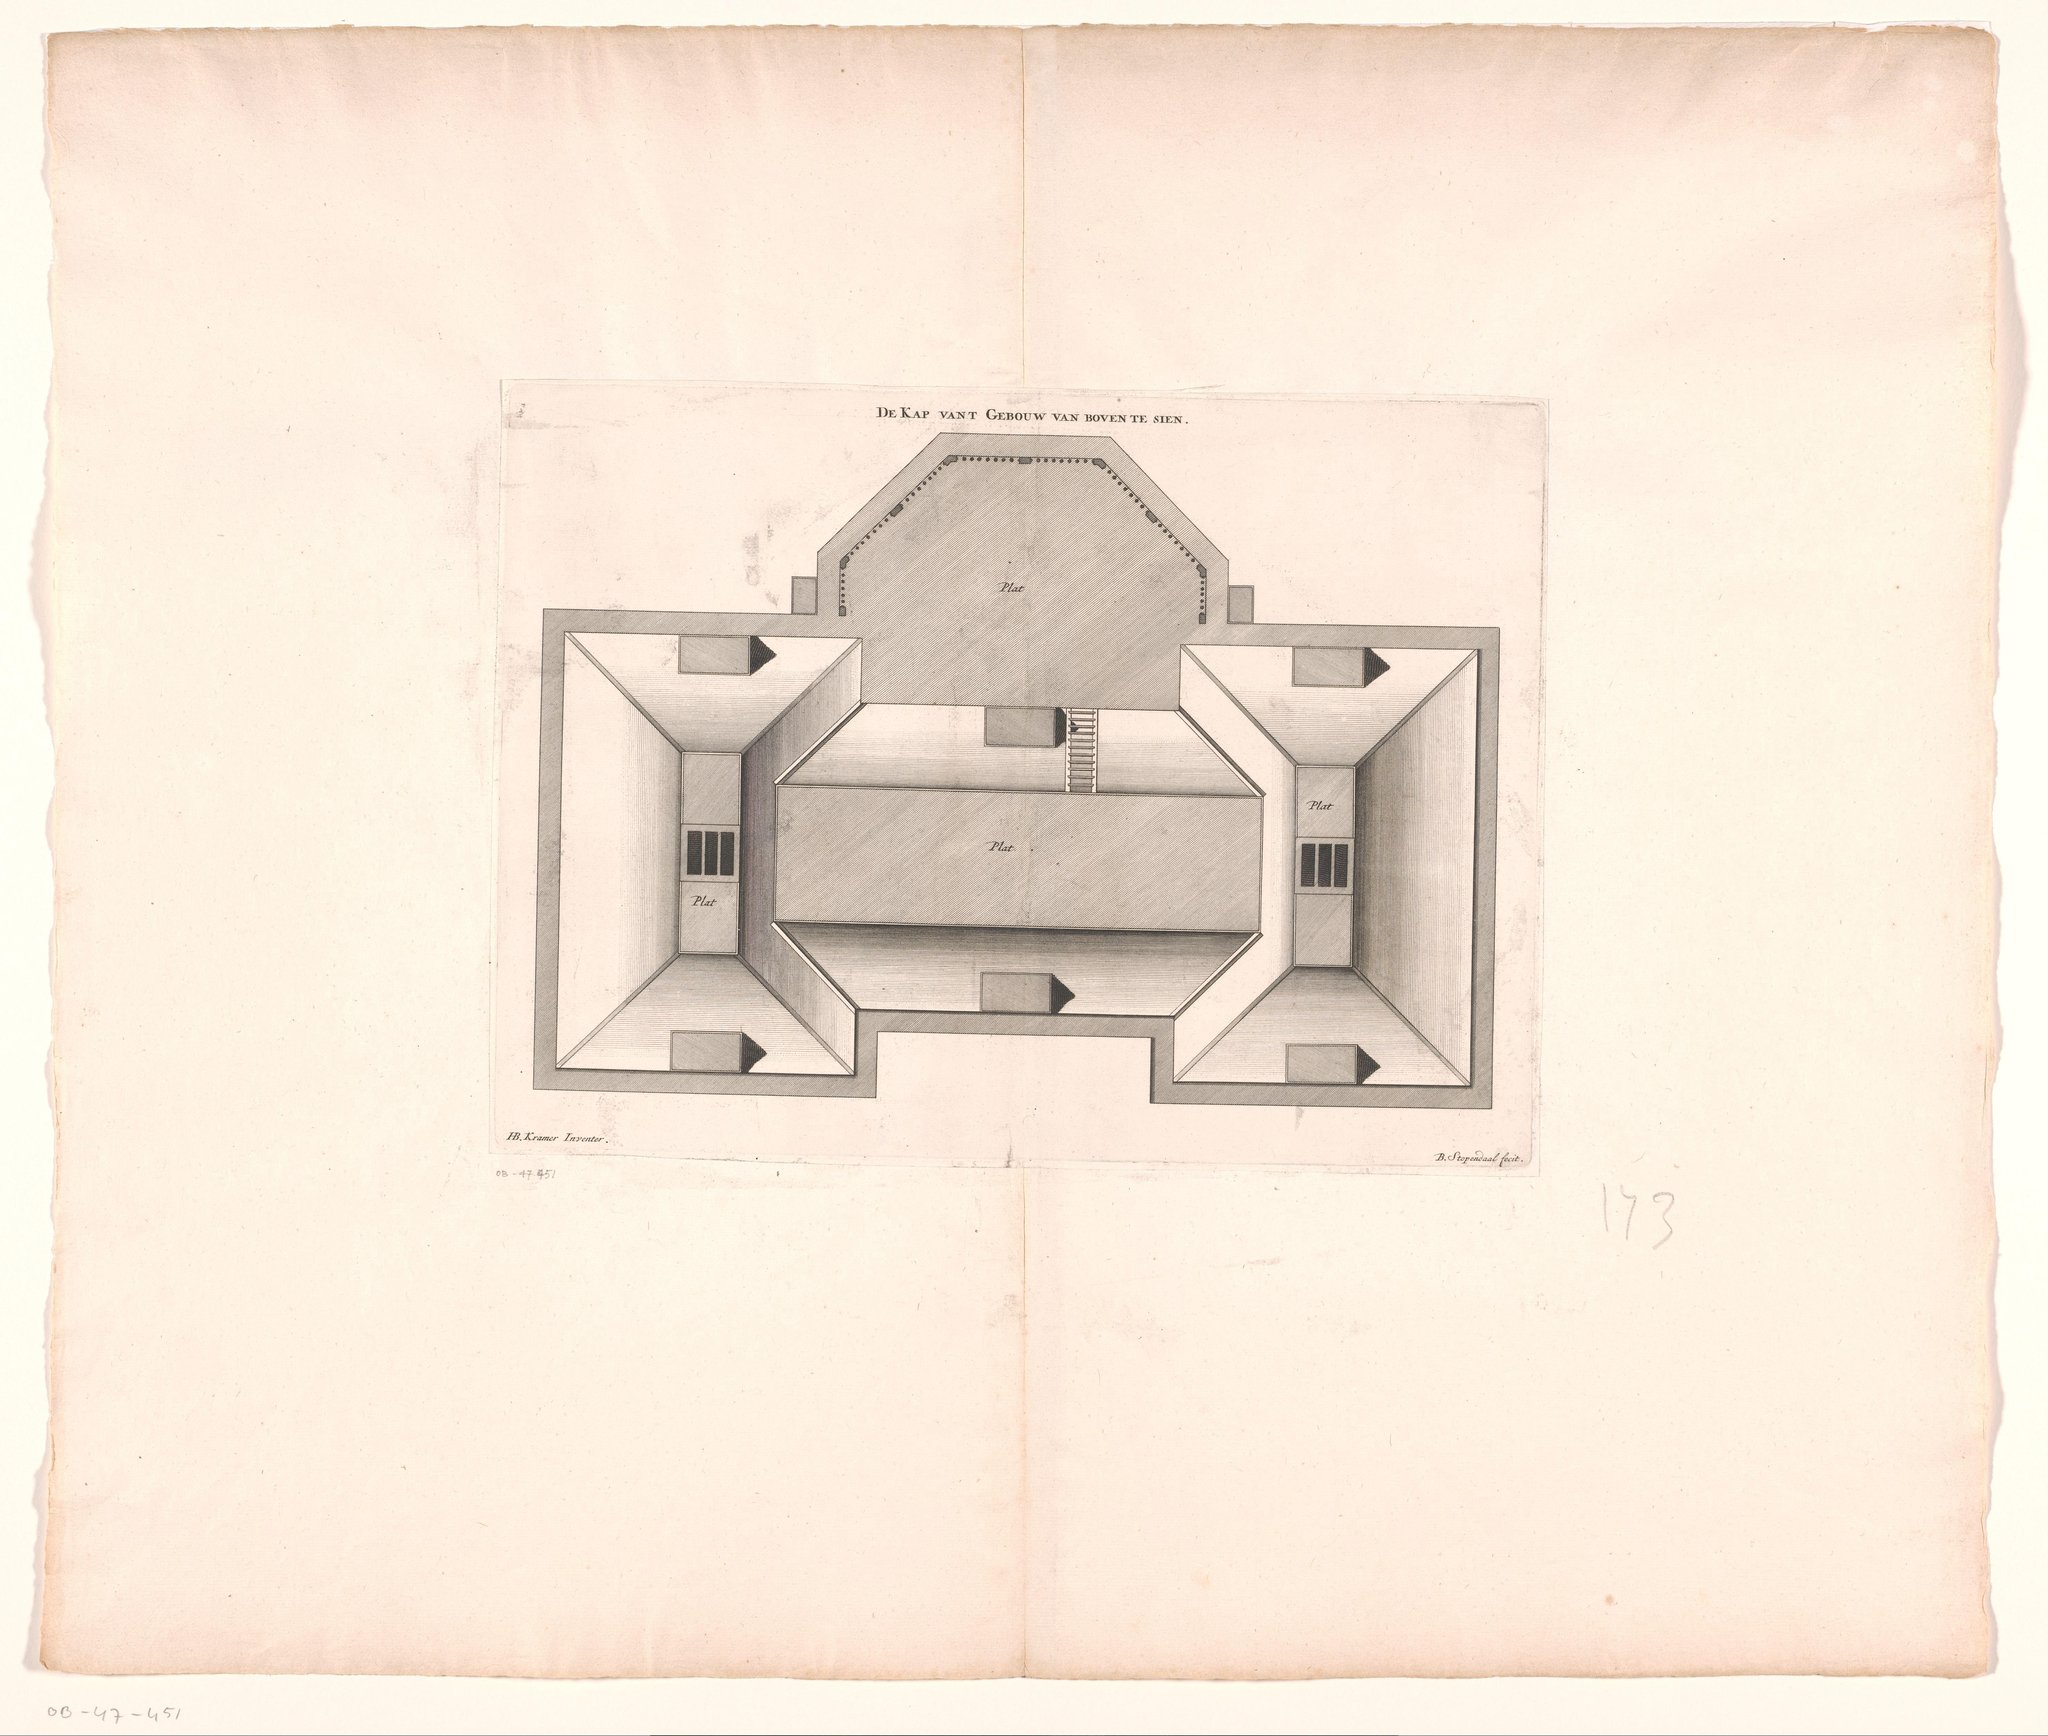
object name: ornament print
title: De Kap van t Gebouw van boven te sien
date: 1687-1693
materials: paper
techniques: engraving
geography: amsterdam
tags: architectural design or model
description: Bovenaanzicht van het dak van huis De Nes te Vreeland. Het voor de Amsterdamse familie Reaal in 1687 gebouwde buitenhuis lag op een eiland in de Vecht.